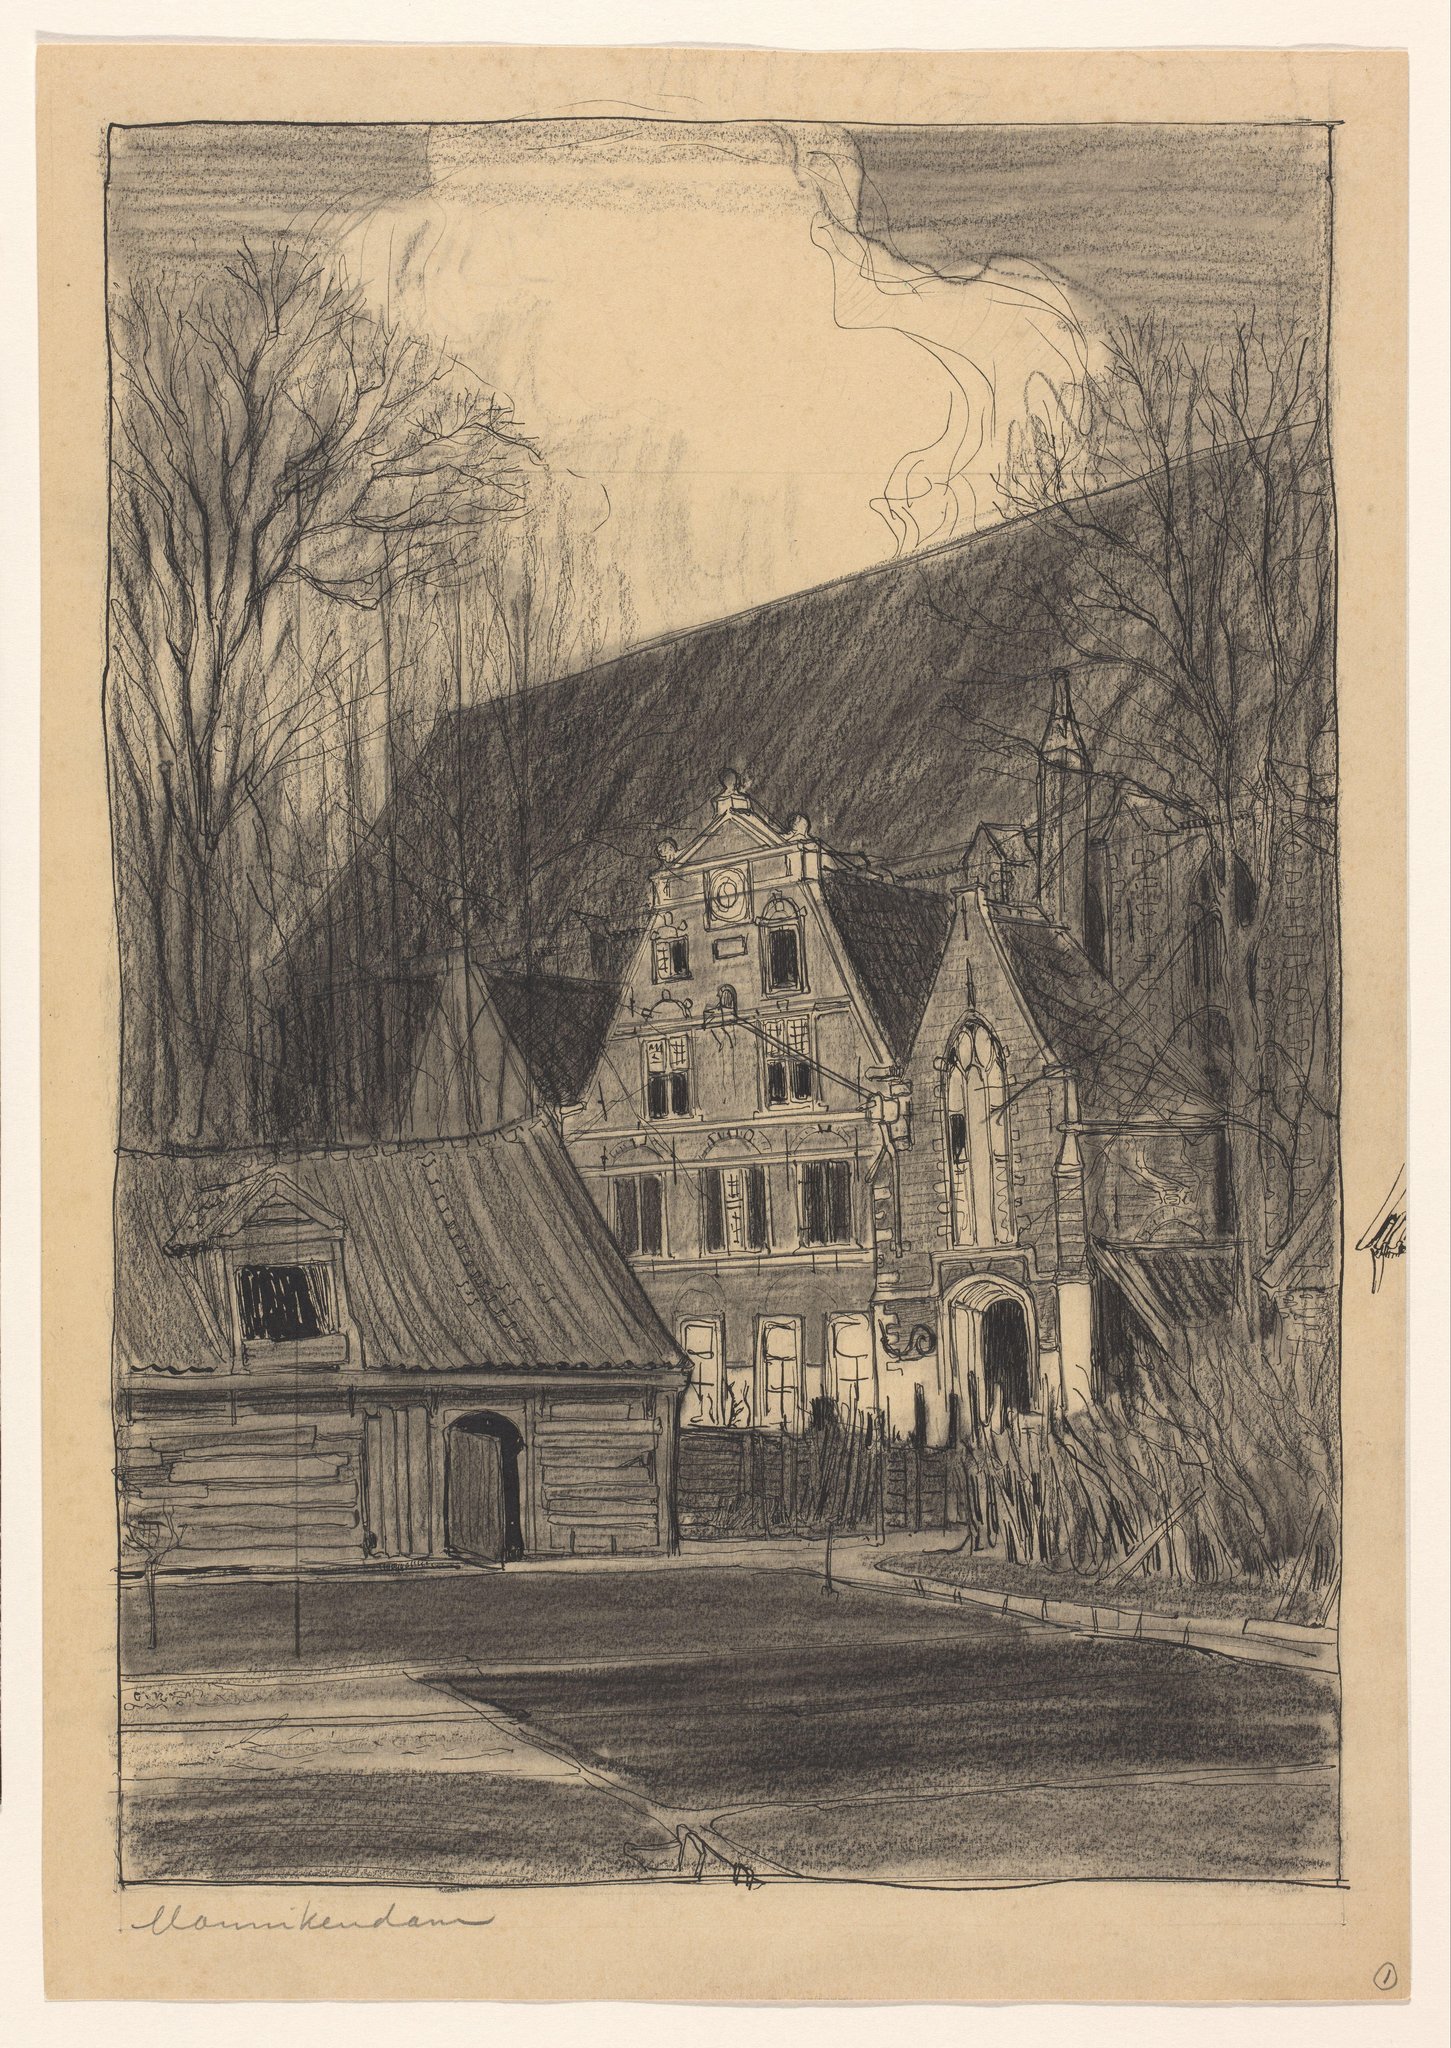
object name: drawing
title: Noordzijde van de Grote of Sint-Nicolaaskerk te Monnickendam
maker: wijnand otto jan nieuwenkamp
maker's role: draughtsman, print maker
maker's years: 1874-1950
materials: chalk, ink, paper, pencil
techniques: pen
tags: church (exterior)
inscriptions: number: ‘1’, inscription: ‘Monnikendam’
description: Ontwerp voor: Nieuwenkamp, W.O.J. en Veldheer, J.G. Oude Hollandsche steden aan de Zuiderzee. Haarlem: De Erven F. Bohn, 1897. De tekening is niet opgenomen in de publicatie.